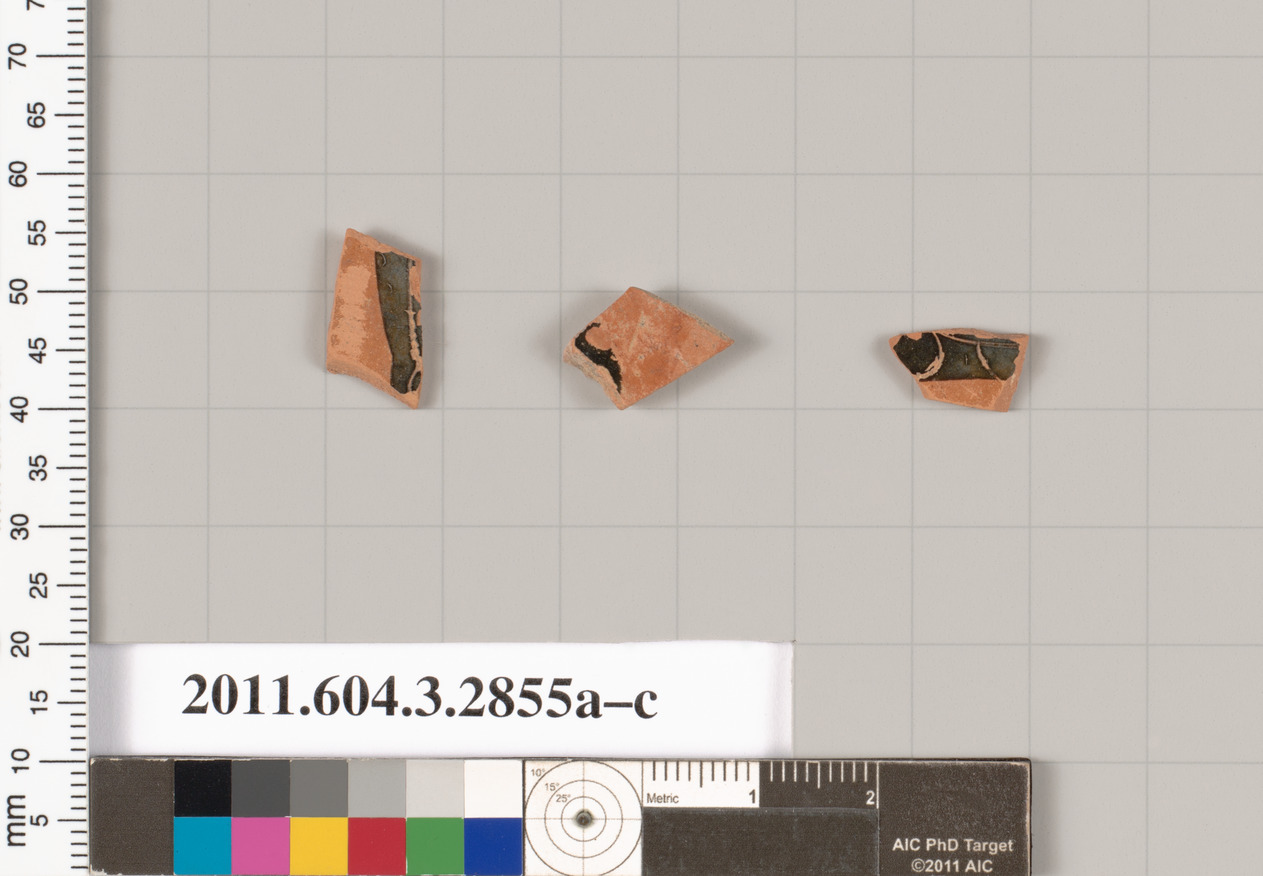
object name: undetermined closed shape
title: Terracotta fragments of closed shapes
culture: greek, attic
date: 534-468 BCE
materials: terracotta